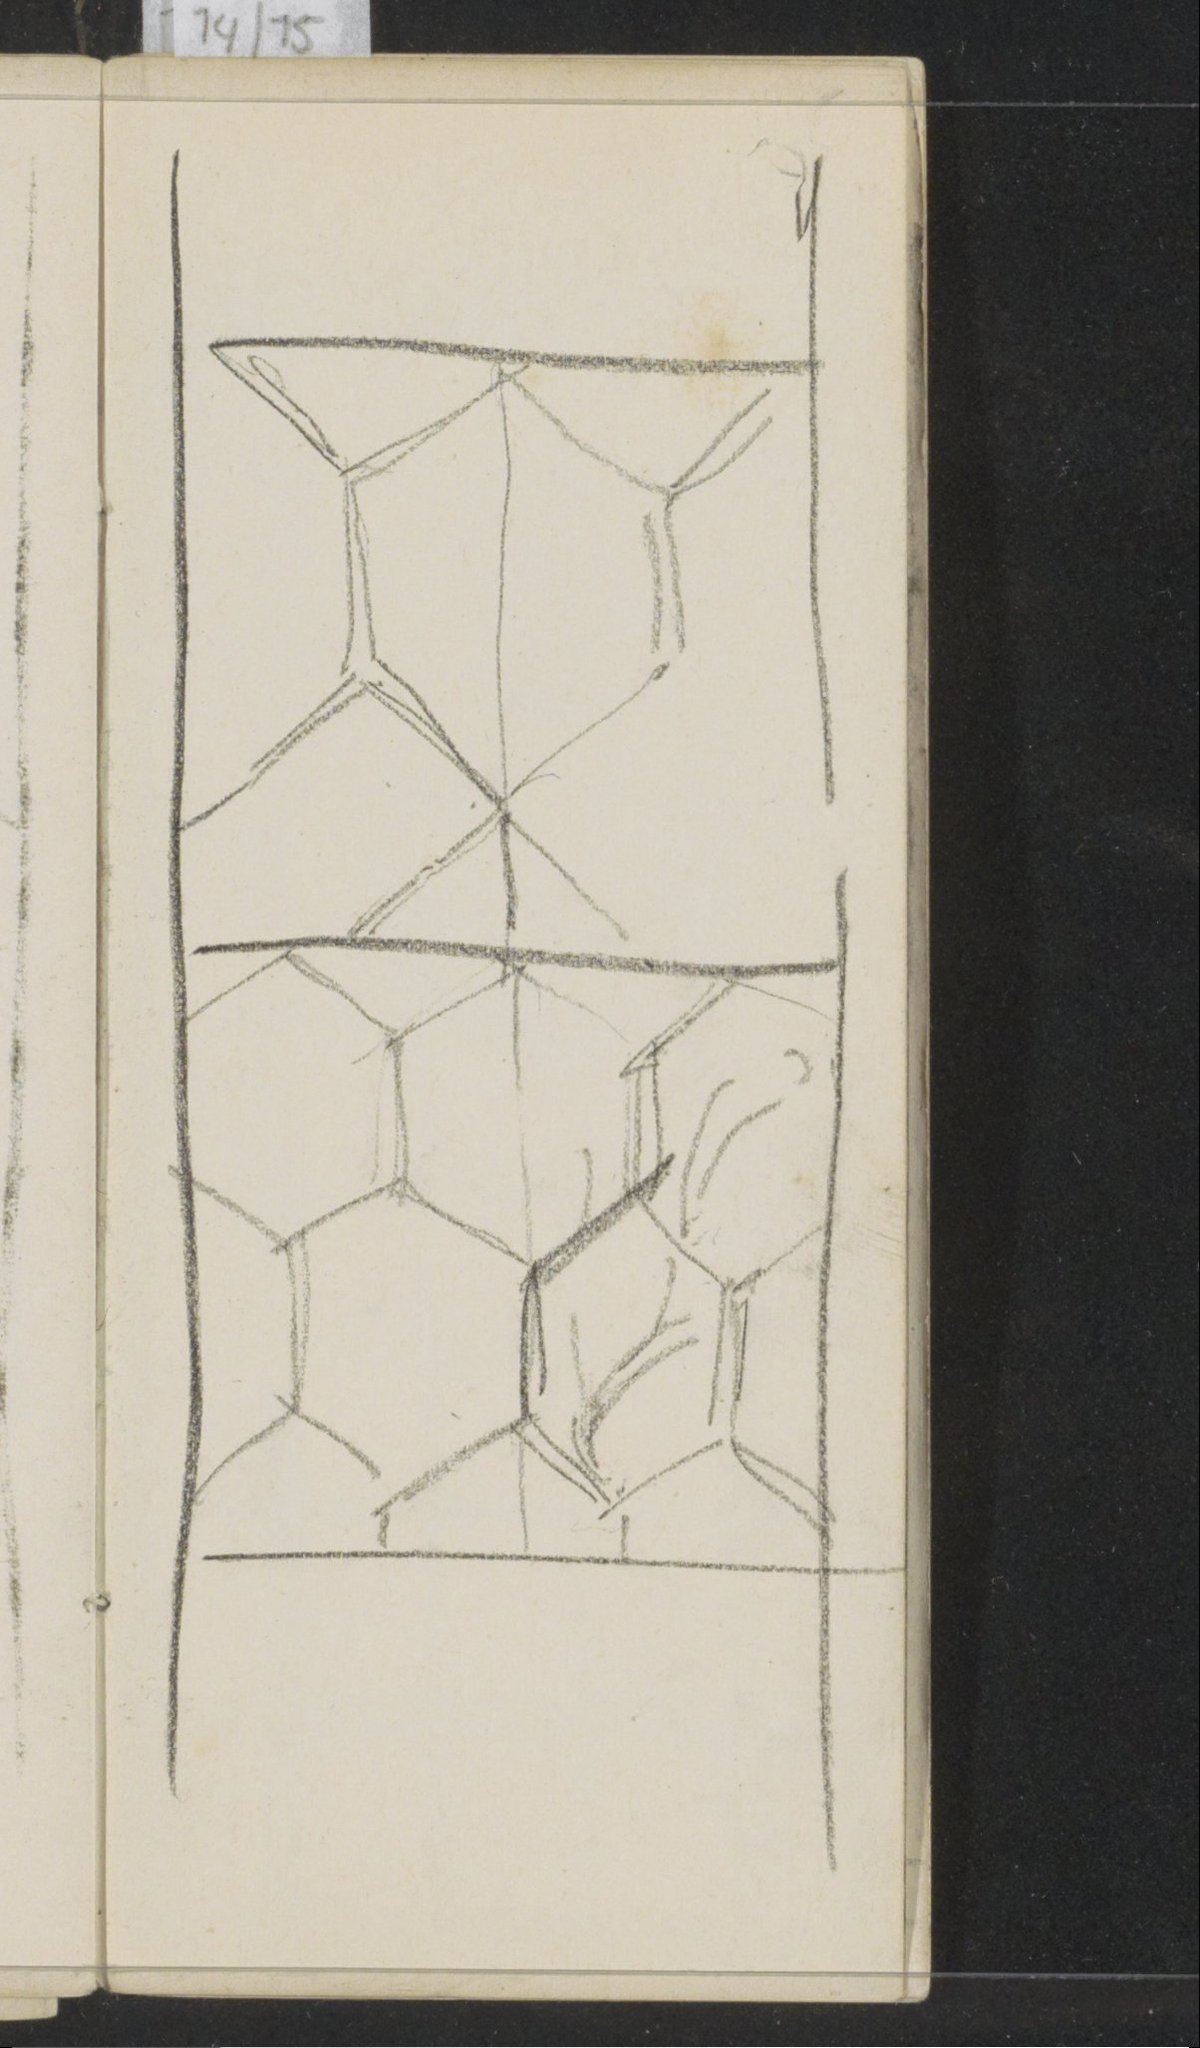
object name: sketchbook leaf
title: Ontwerp voor een venster met honingraatpatroon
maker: gerrit willem dijsselhof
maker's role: designer, draughtsman, print maker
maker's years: 1866-1924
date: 1876-1924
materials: chalk, paper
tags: window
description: Blad 13 recto uit een schetsboek met 24 bladen.